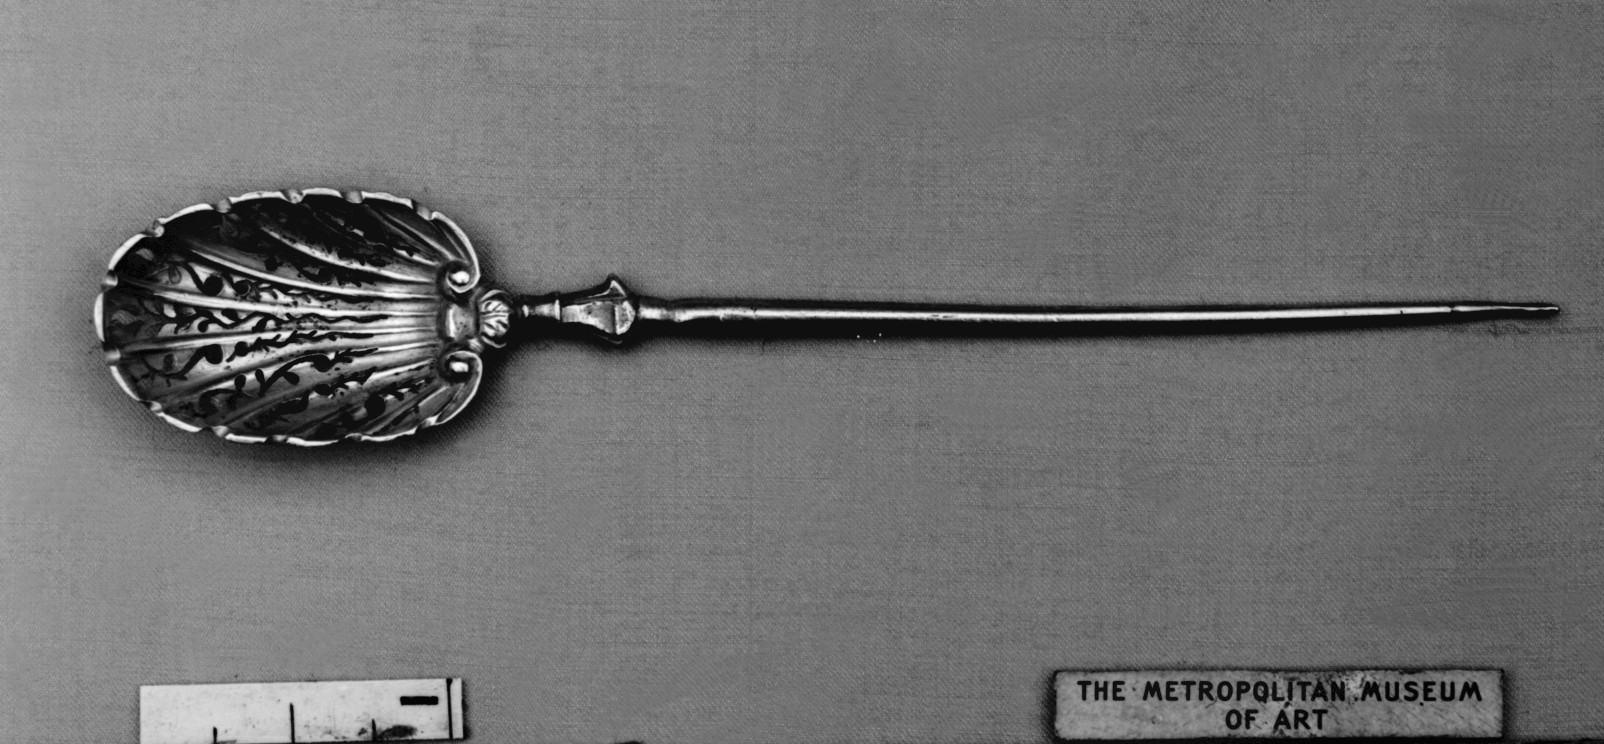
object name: strainer spoon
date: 1801-1900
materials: silver